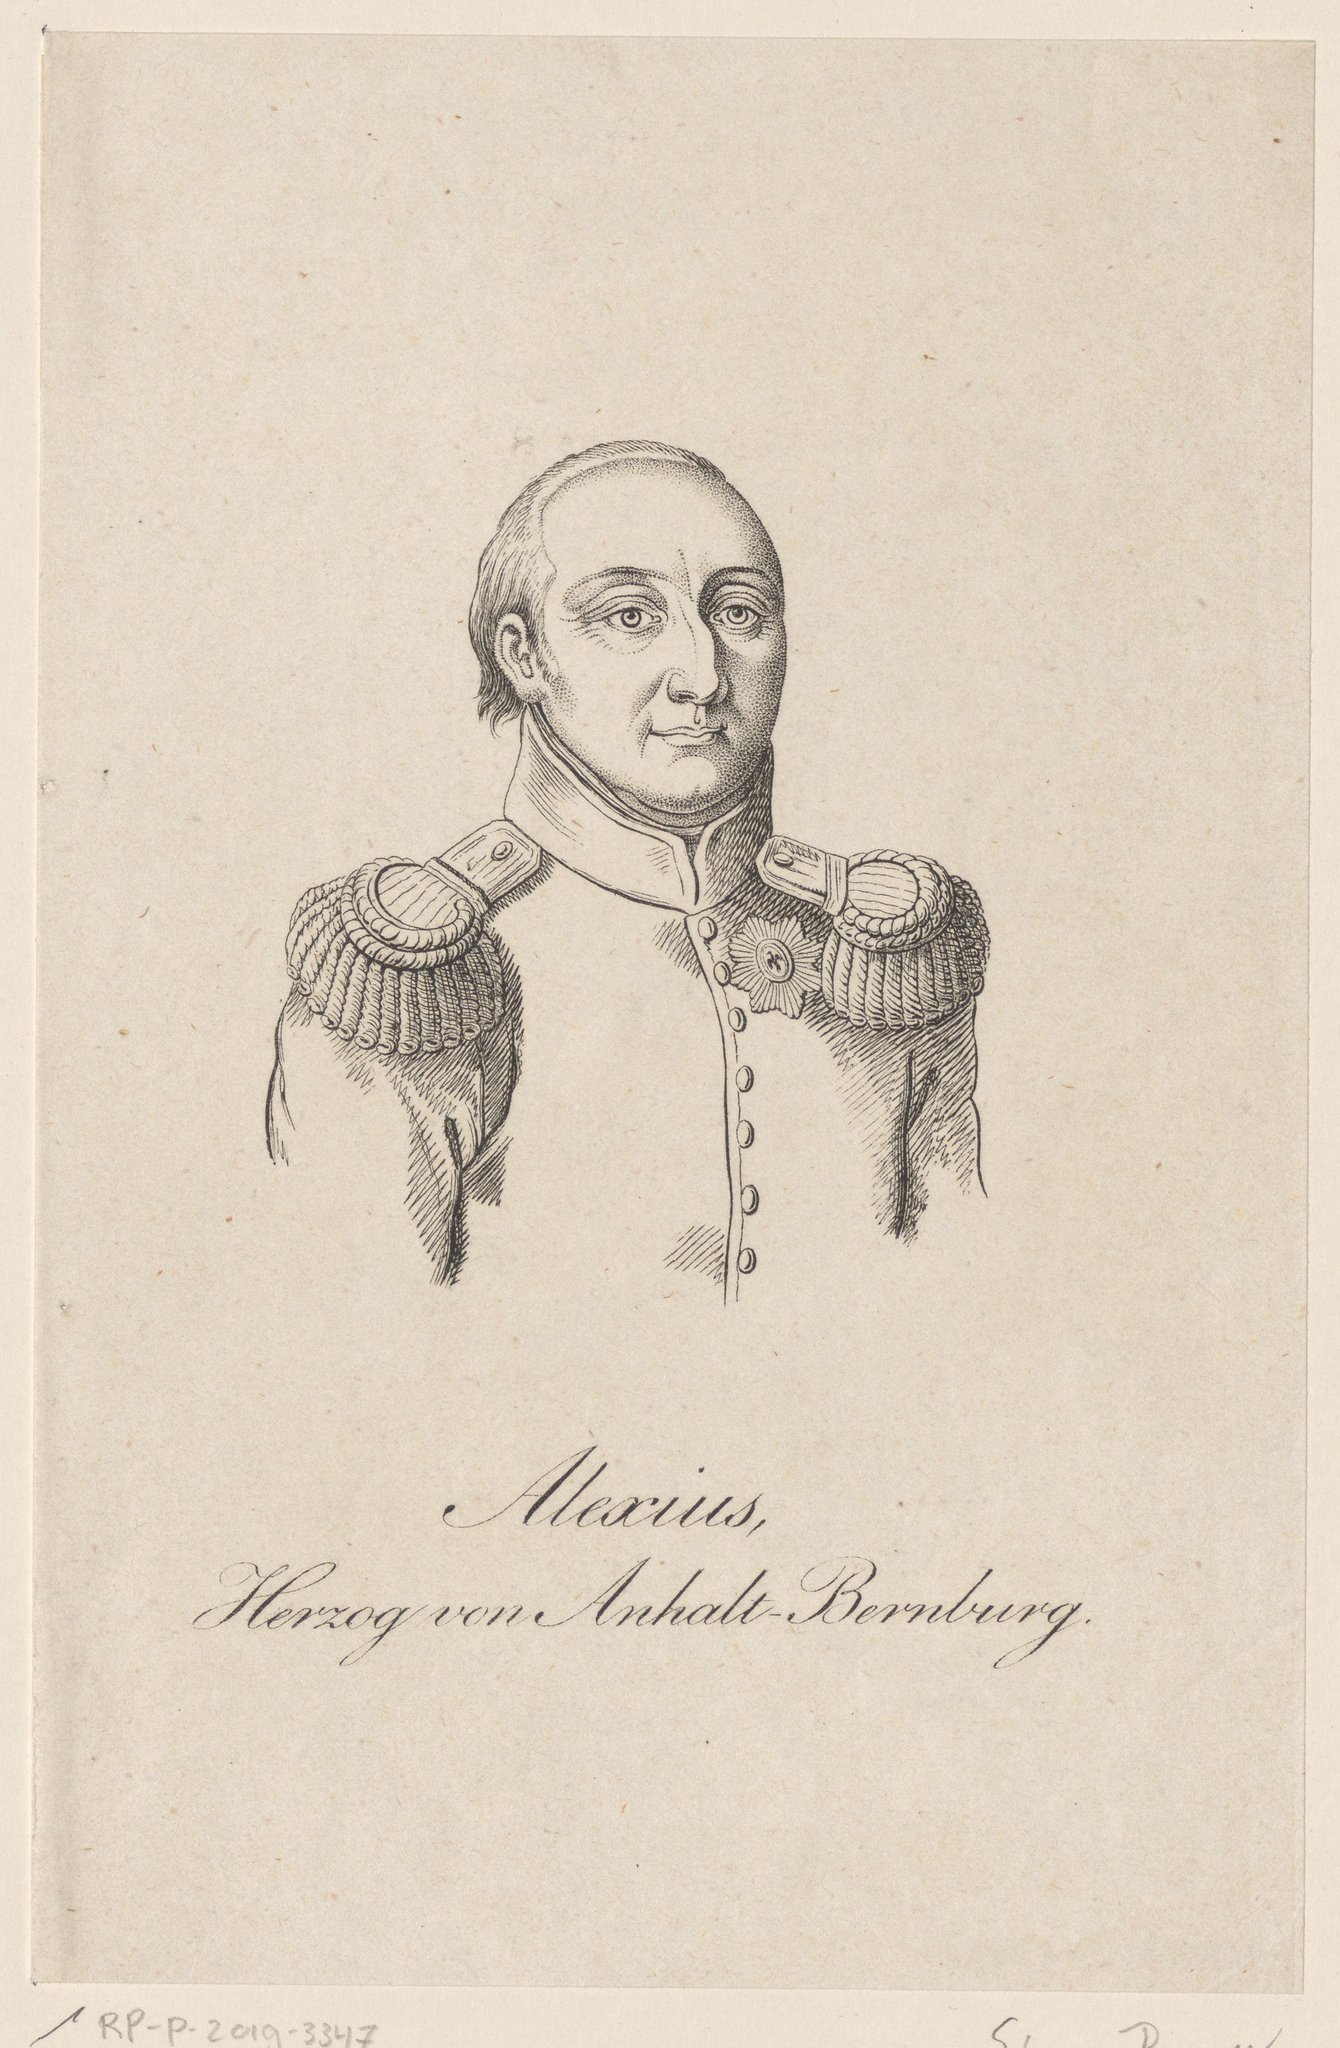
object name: print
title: Portret van Alexius, hertog van Anhalt-Bernburg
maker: Anonymous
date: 1807-1899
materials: paper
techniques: etching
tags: historical persons